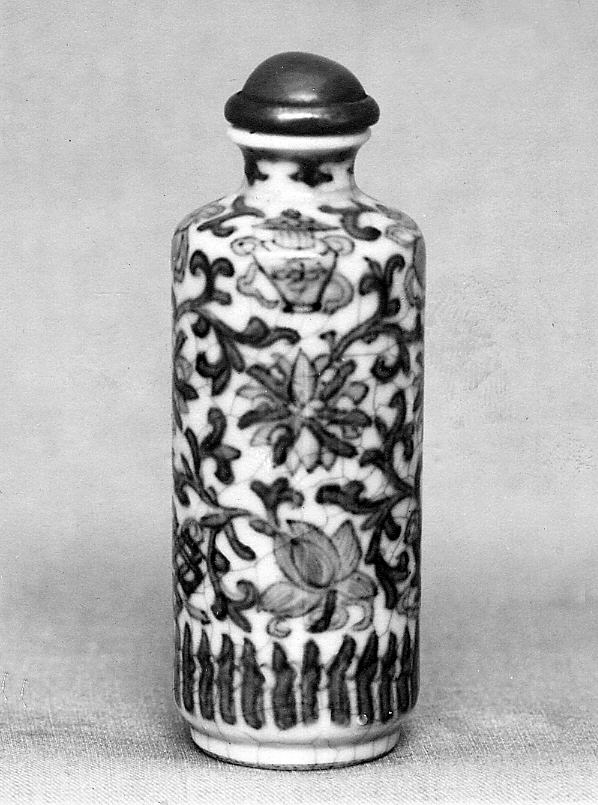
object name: snuff bottle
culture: chinese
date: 1736-1795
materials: soft paste porcelain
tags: lotuses